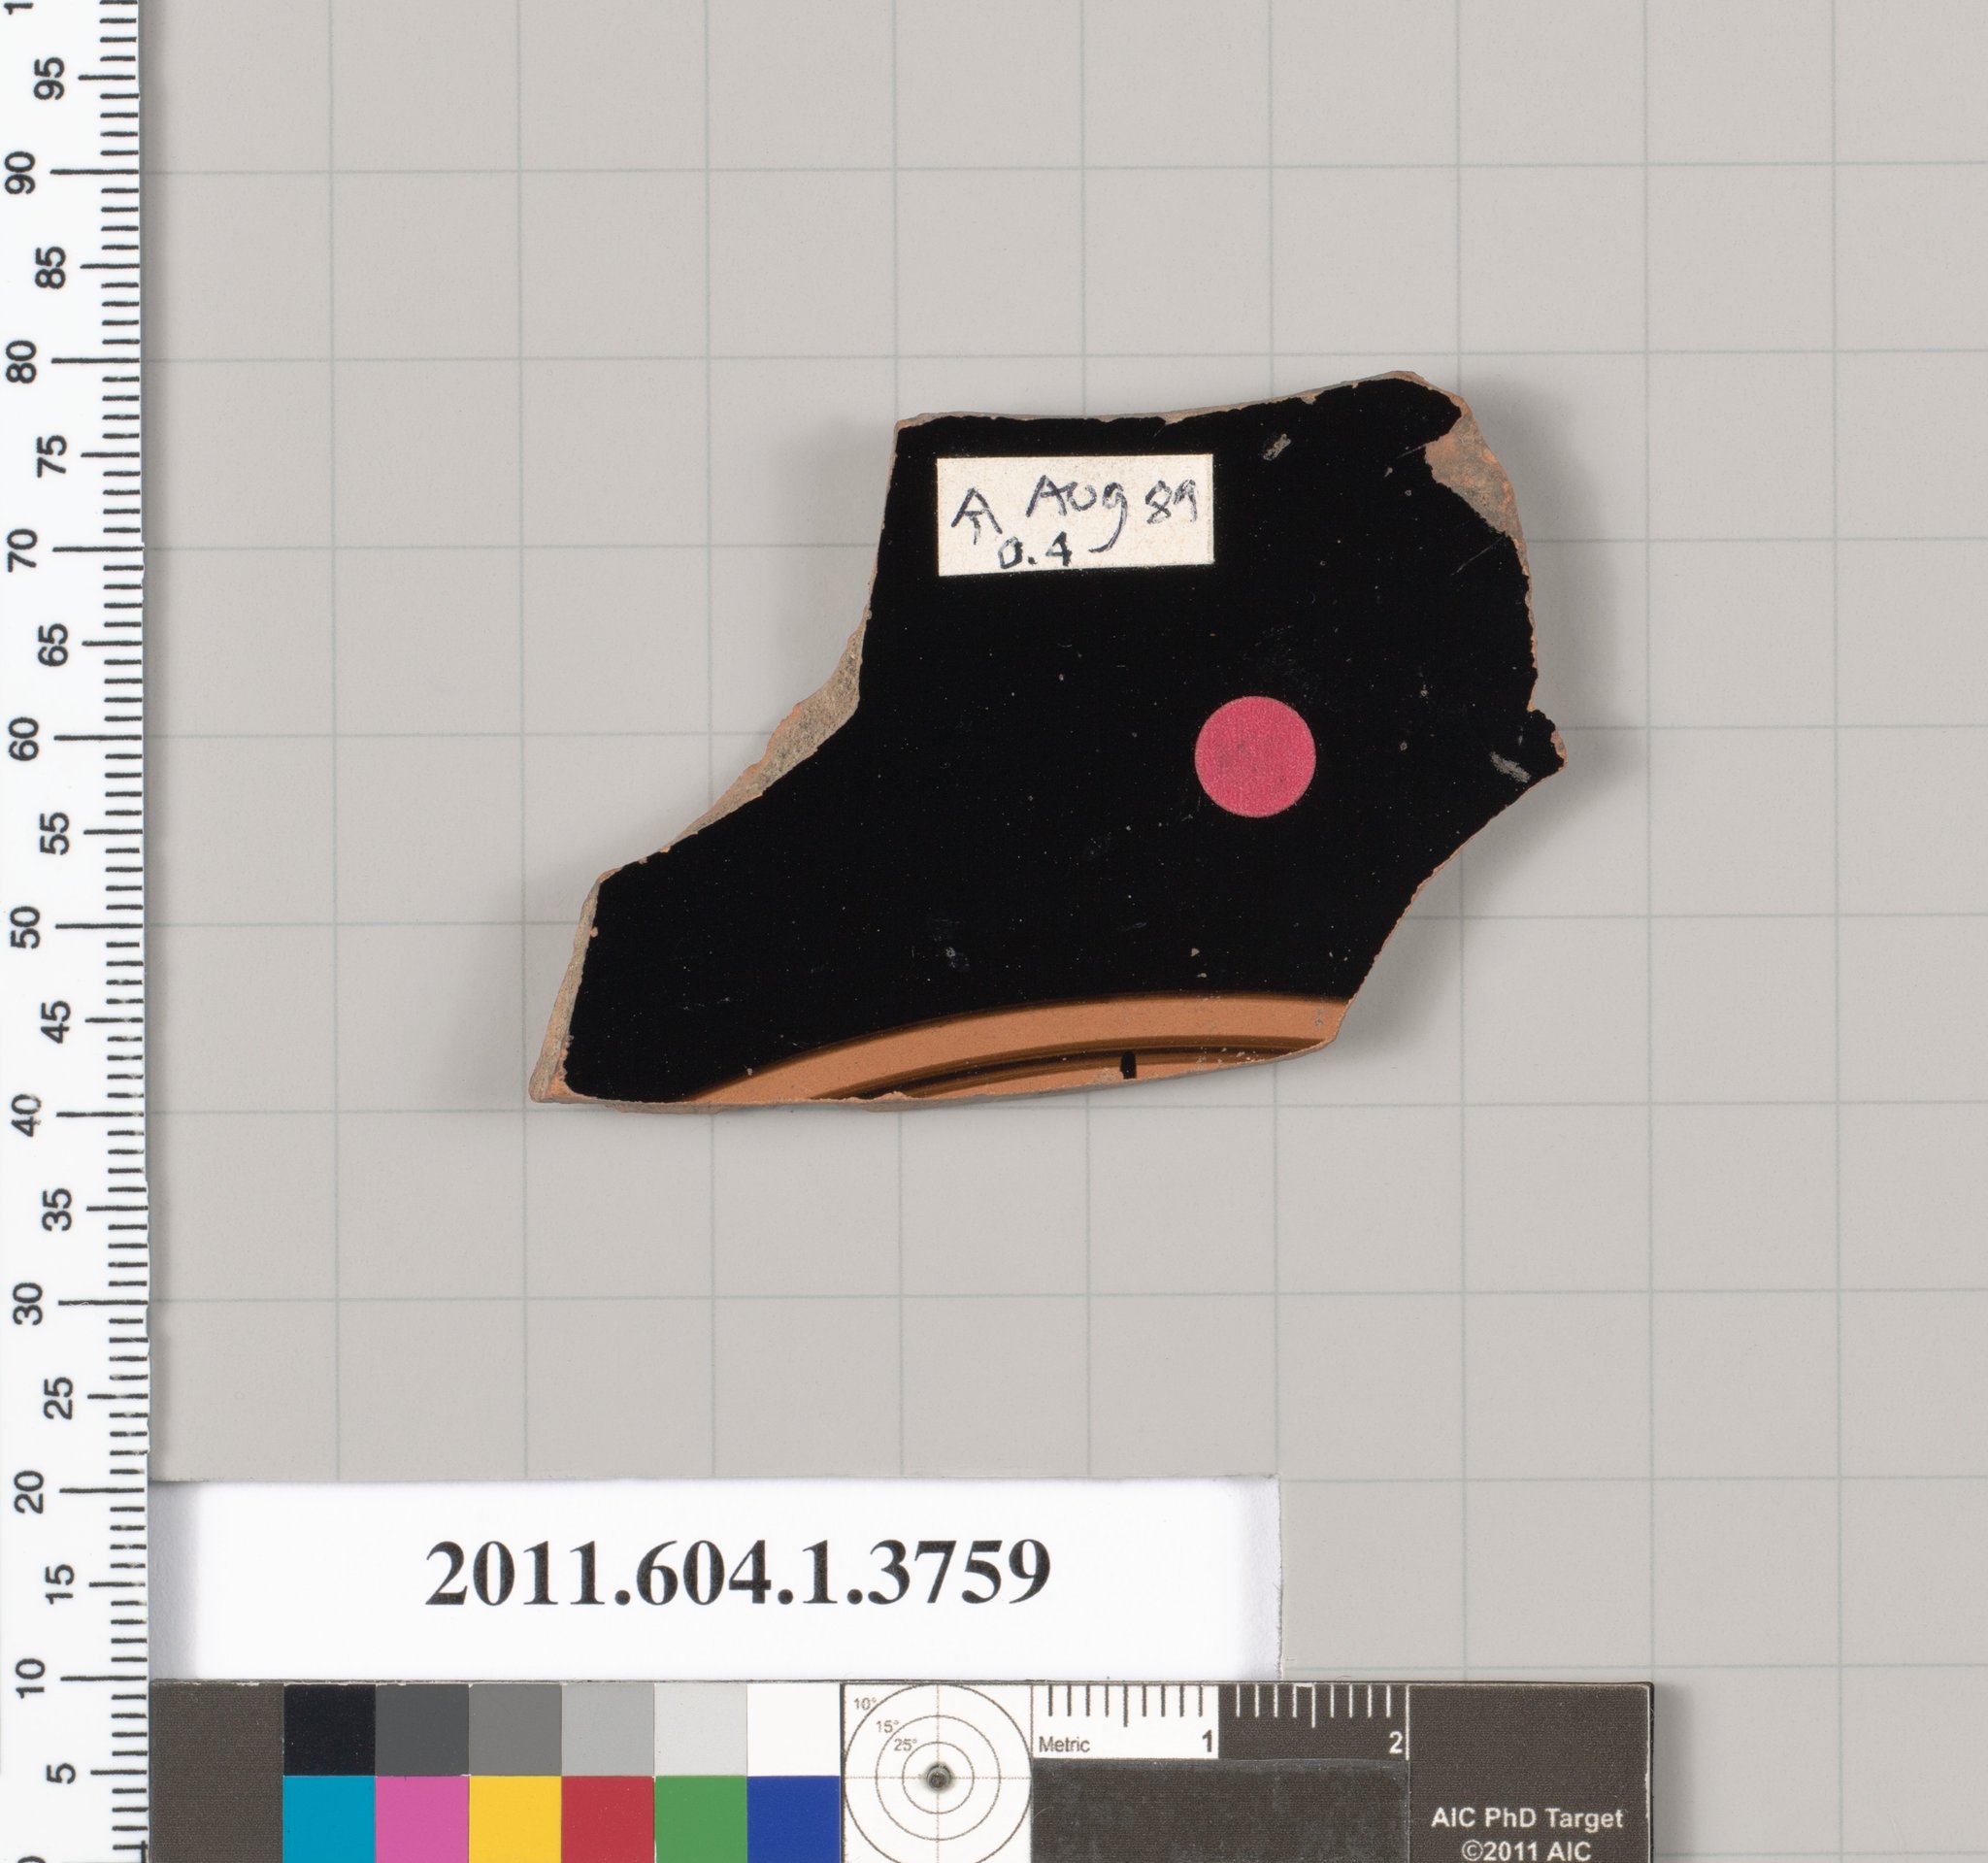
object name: kylix fragment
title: Terracotta fragment of a kylix (drinking cup)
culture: greek, attic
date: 500-470 BCE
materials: terracotta